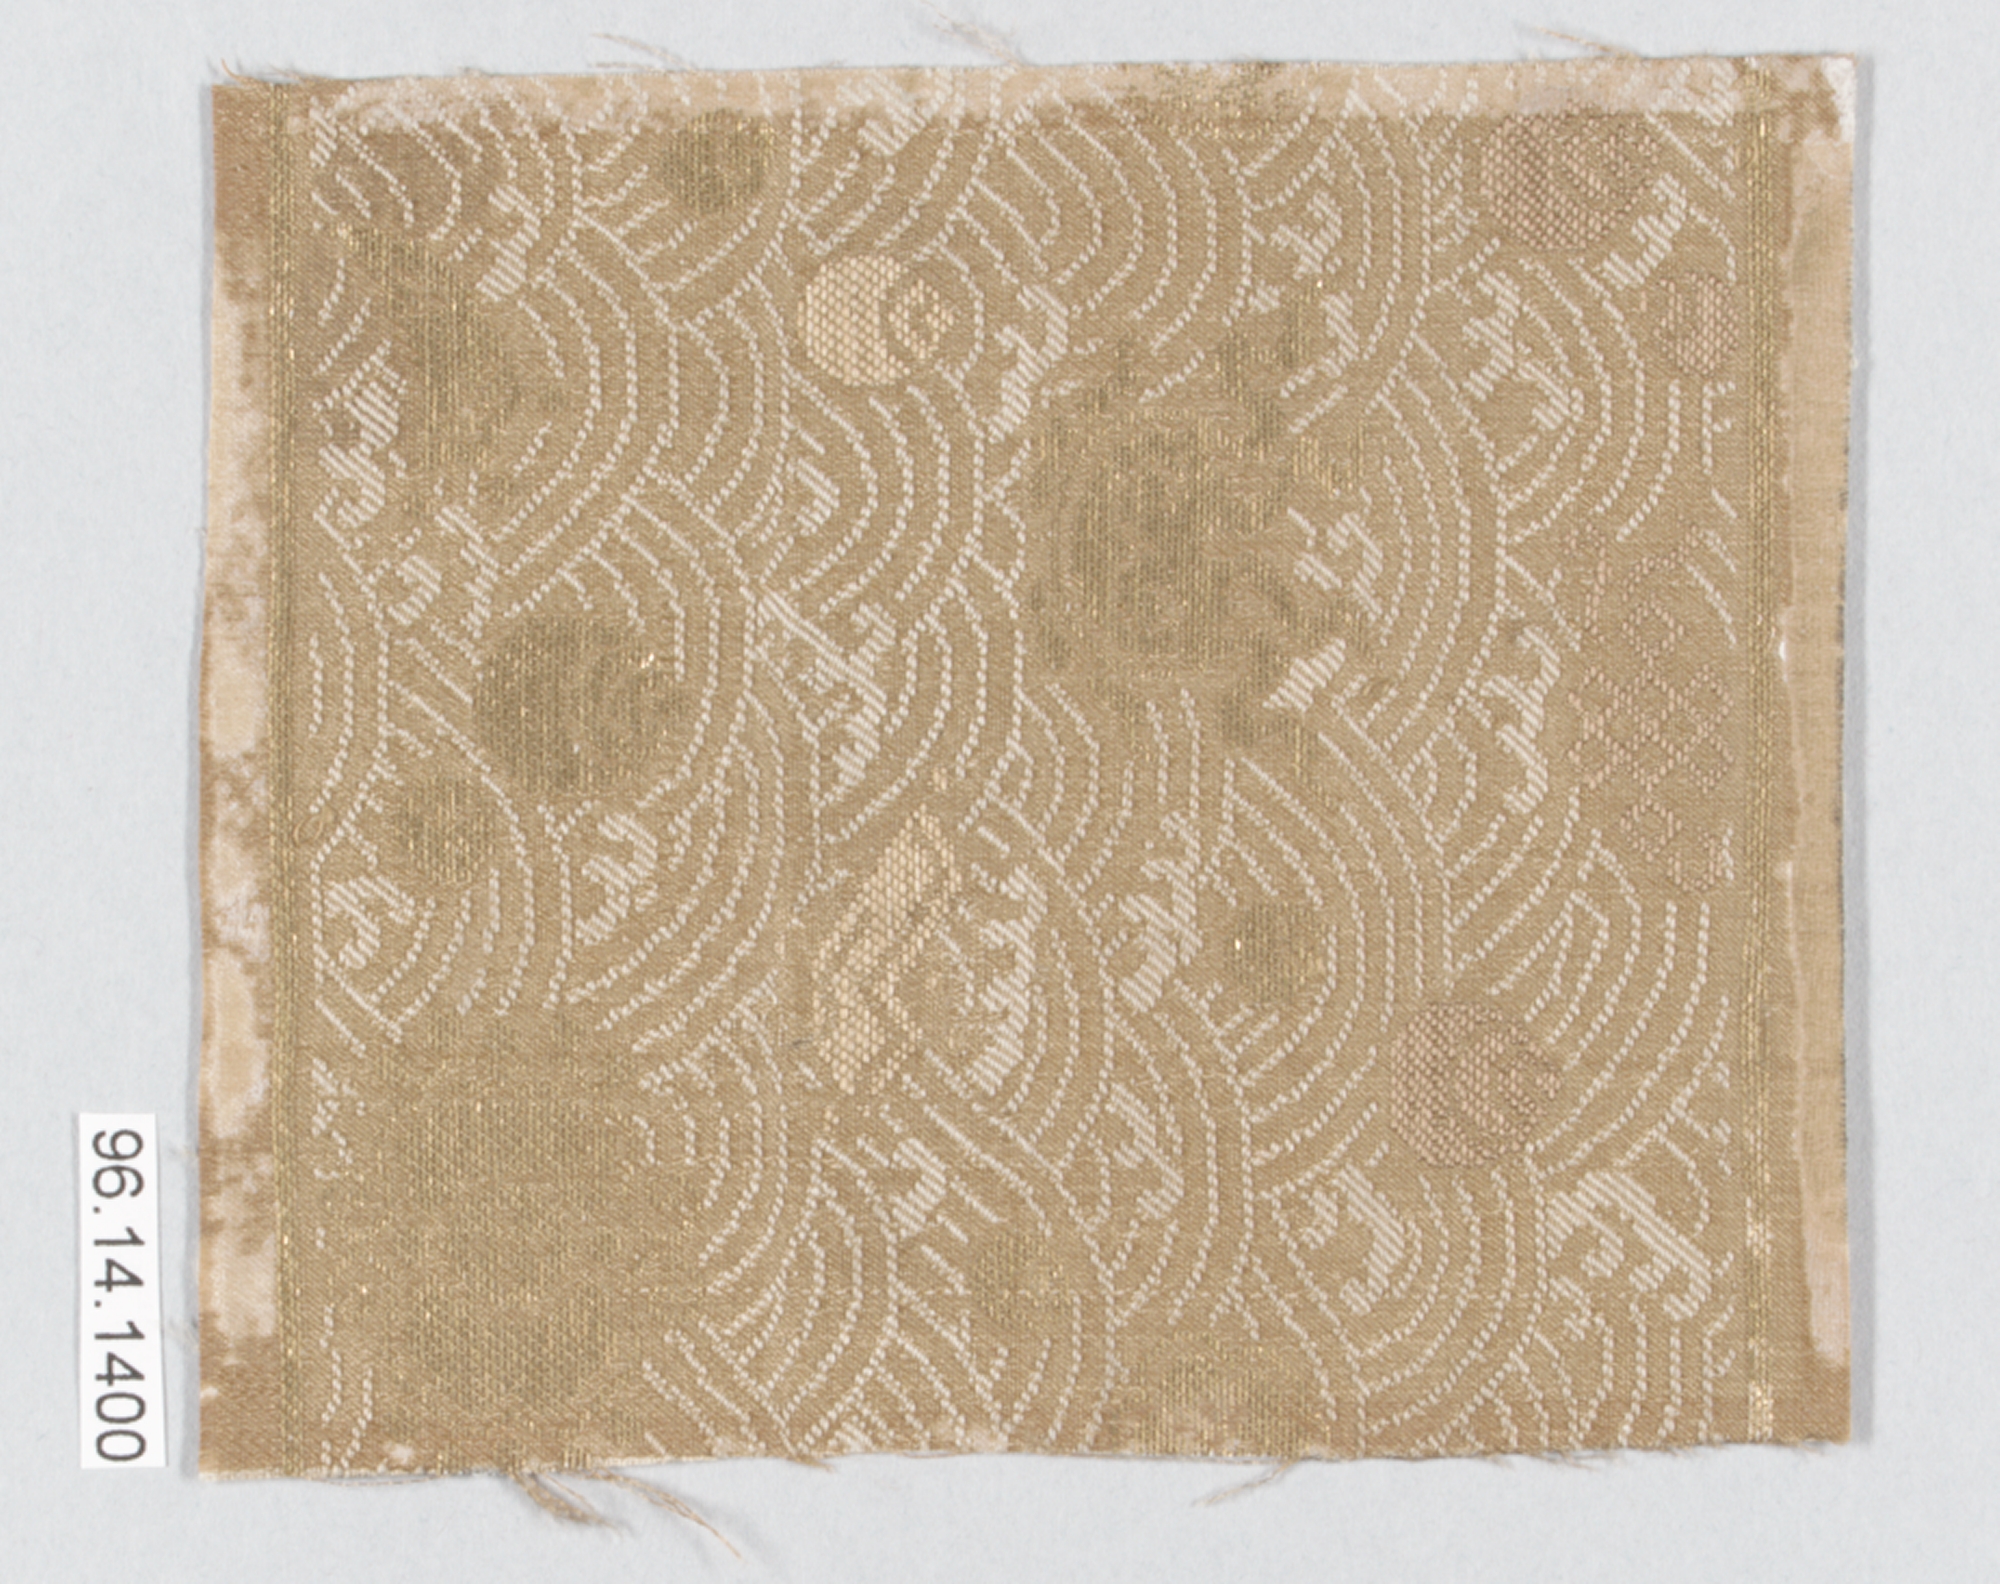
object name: piece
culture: japanese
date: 1801-1900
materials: metal thread, silk